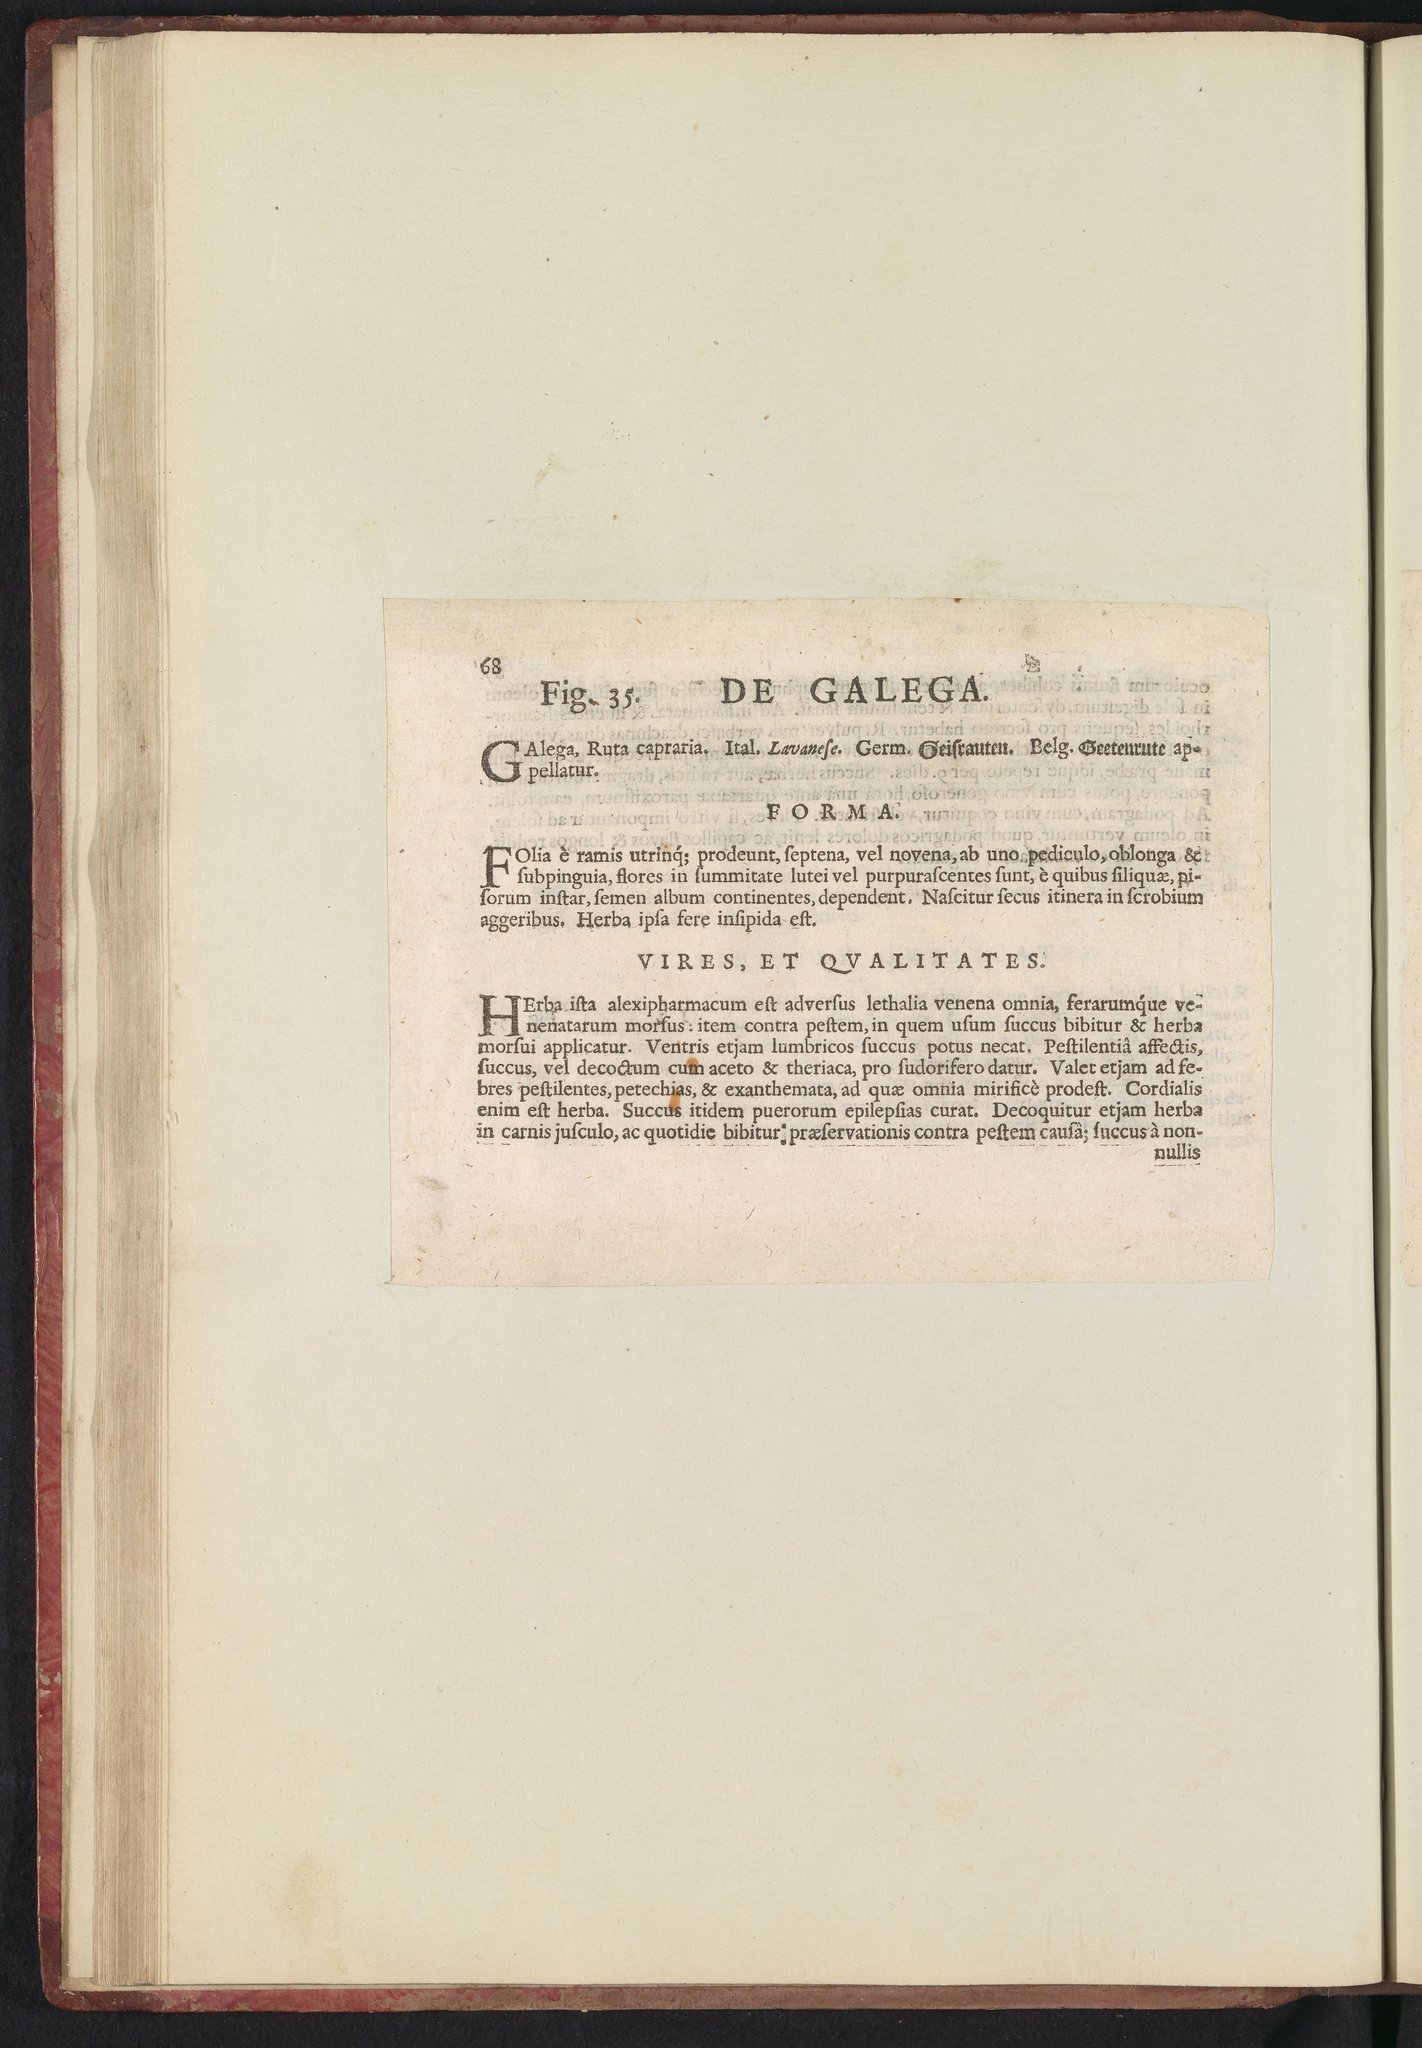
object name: text sheet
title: Fig. 35 'De Galega' in De Boodts herbarium van 1640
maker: anselmus boëtius de boodt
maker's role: draughtsman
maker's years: 1550-1632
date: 1640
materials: ink, paper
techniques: letterpress printing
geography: bruges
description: Beschrijving bij Fig. 35 op p. 68 in: Anselmi Boëtii de Boot I.C. Brugensis & Rodolphi II. Imp. Roman. medici a cubiculis Florum, Herbarum, ac fructuum selectiorum icones, & vires pleraeque hactenus ignotæ. Onderdeel van het album met bladen en platen uit De Boodts herbarium van 1640. Het twaalfde van twaalf albums met aquarellen van dieren, vogels en planten bekend rond 1600, gemaakt in opdracht van keizer Rudolf II.